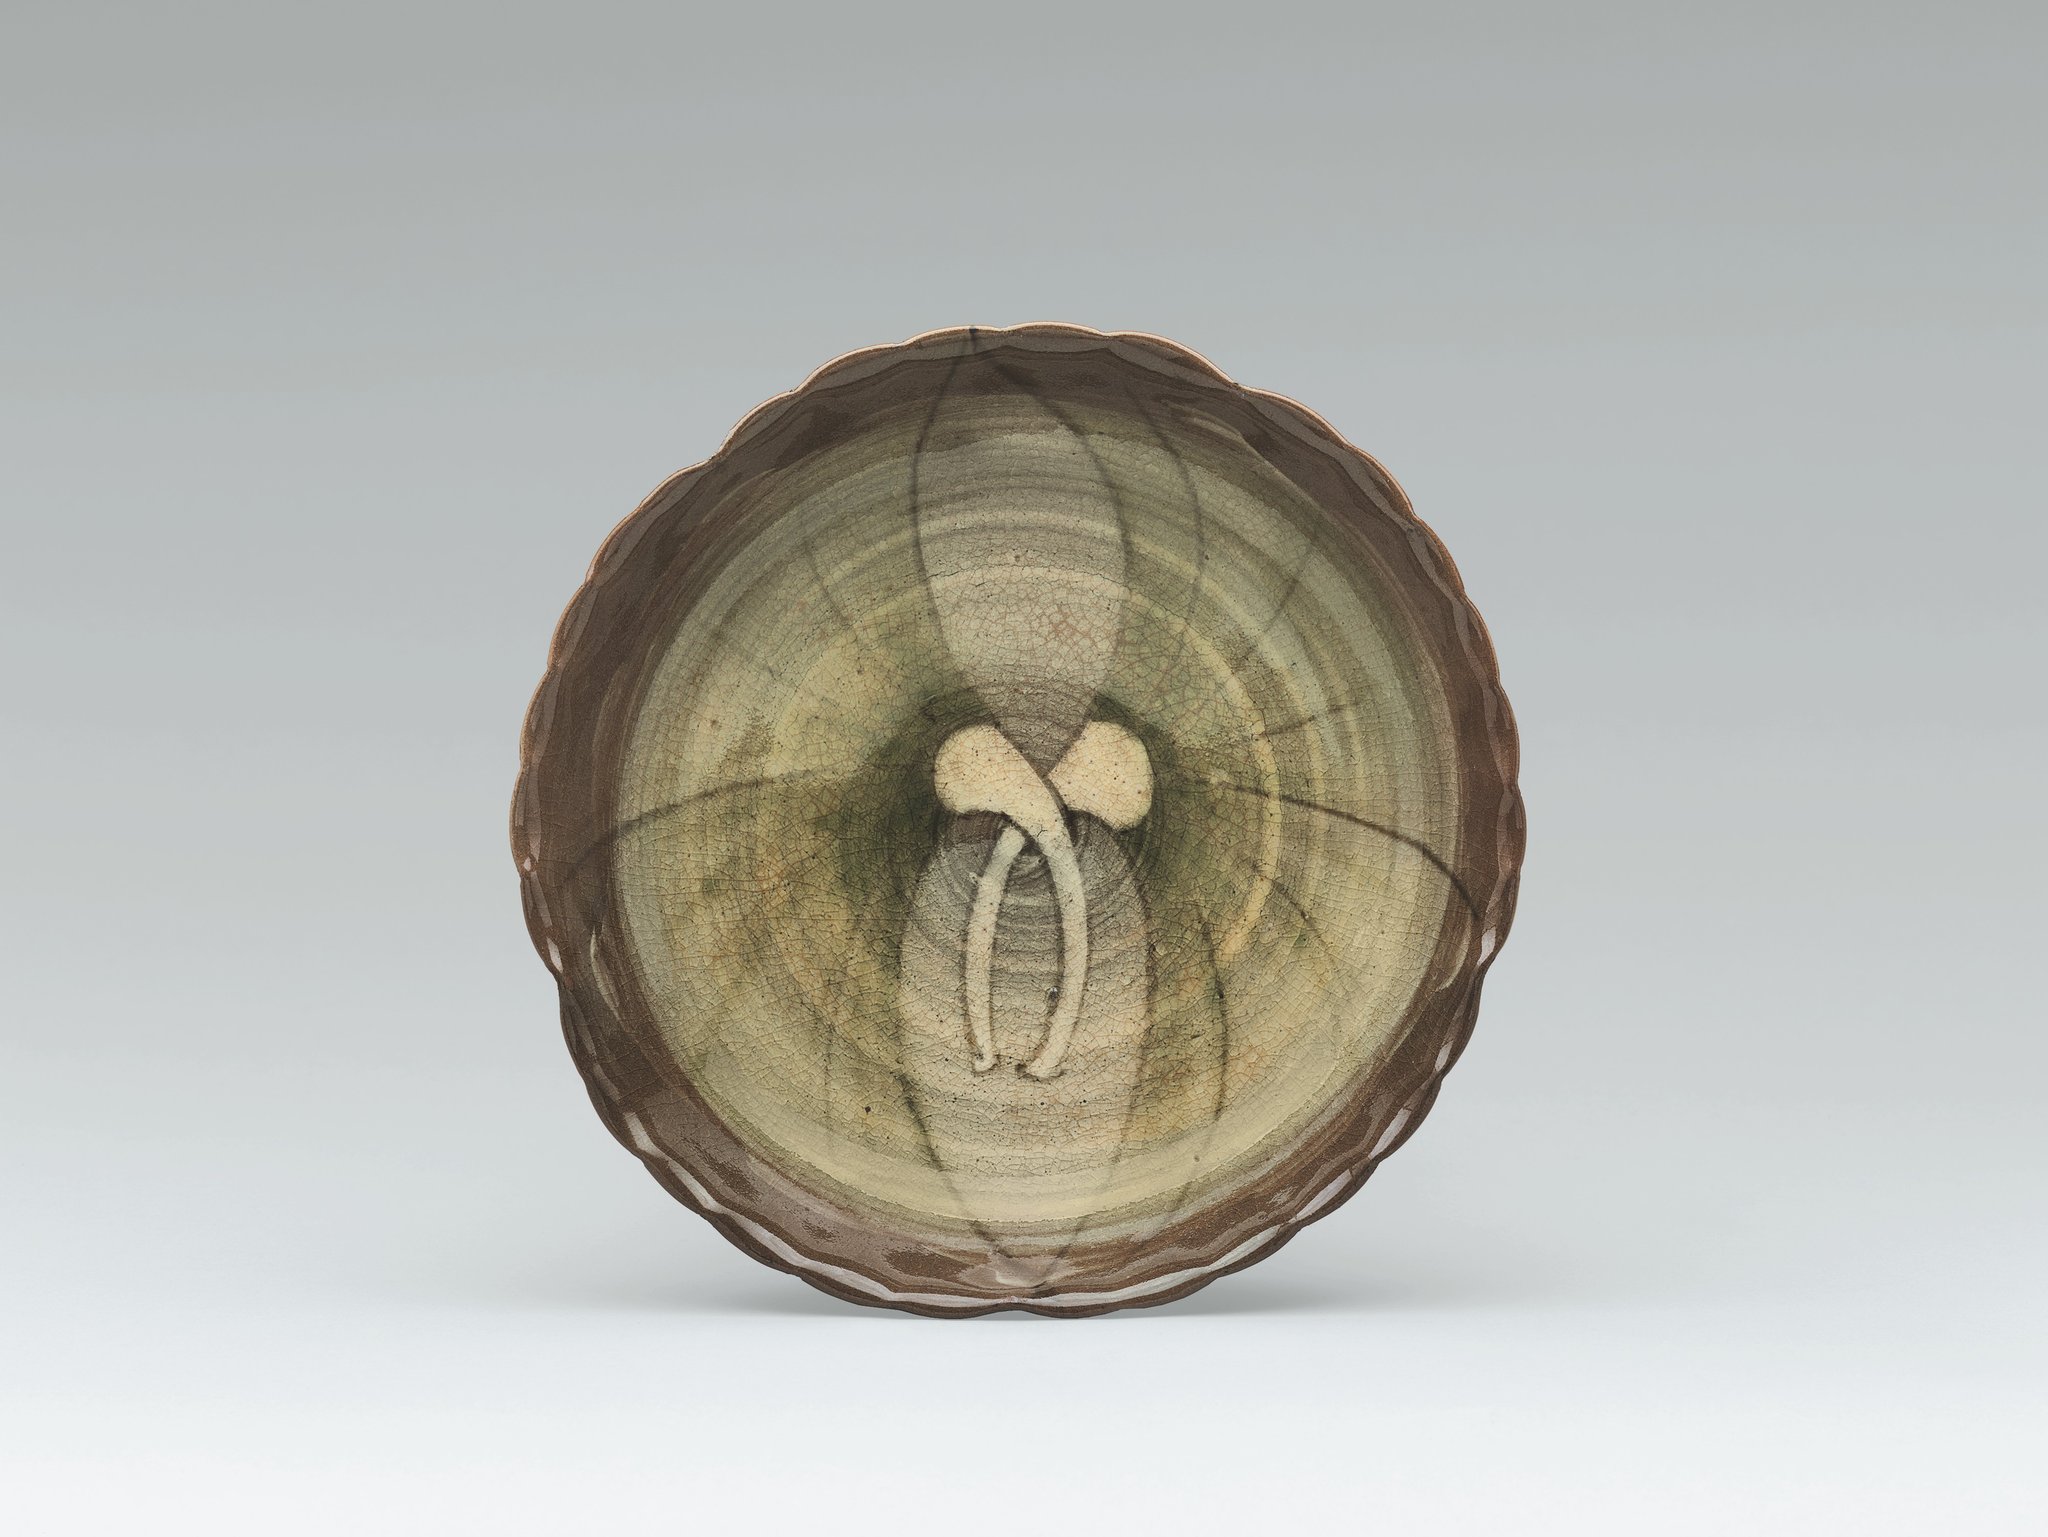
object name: dish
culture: japanese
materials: copper, glaze, iron, stoneware